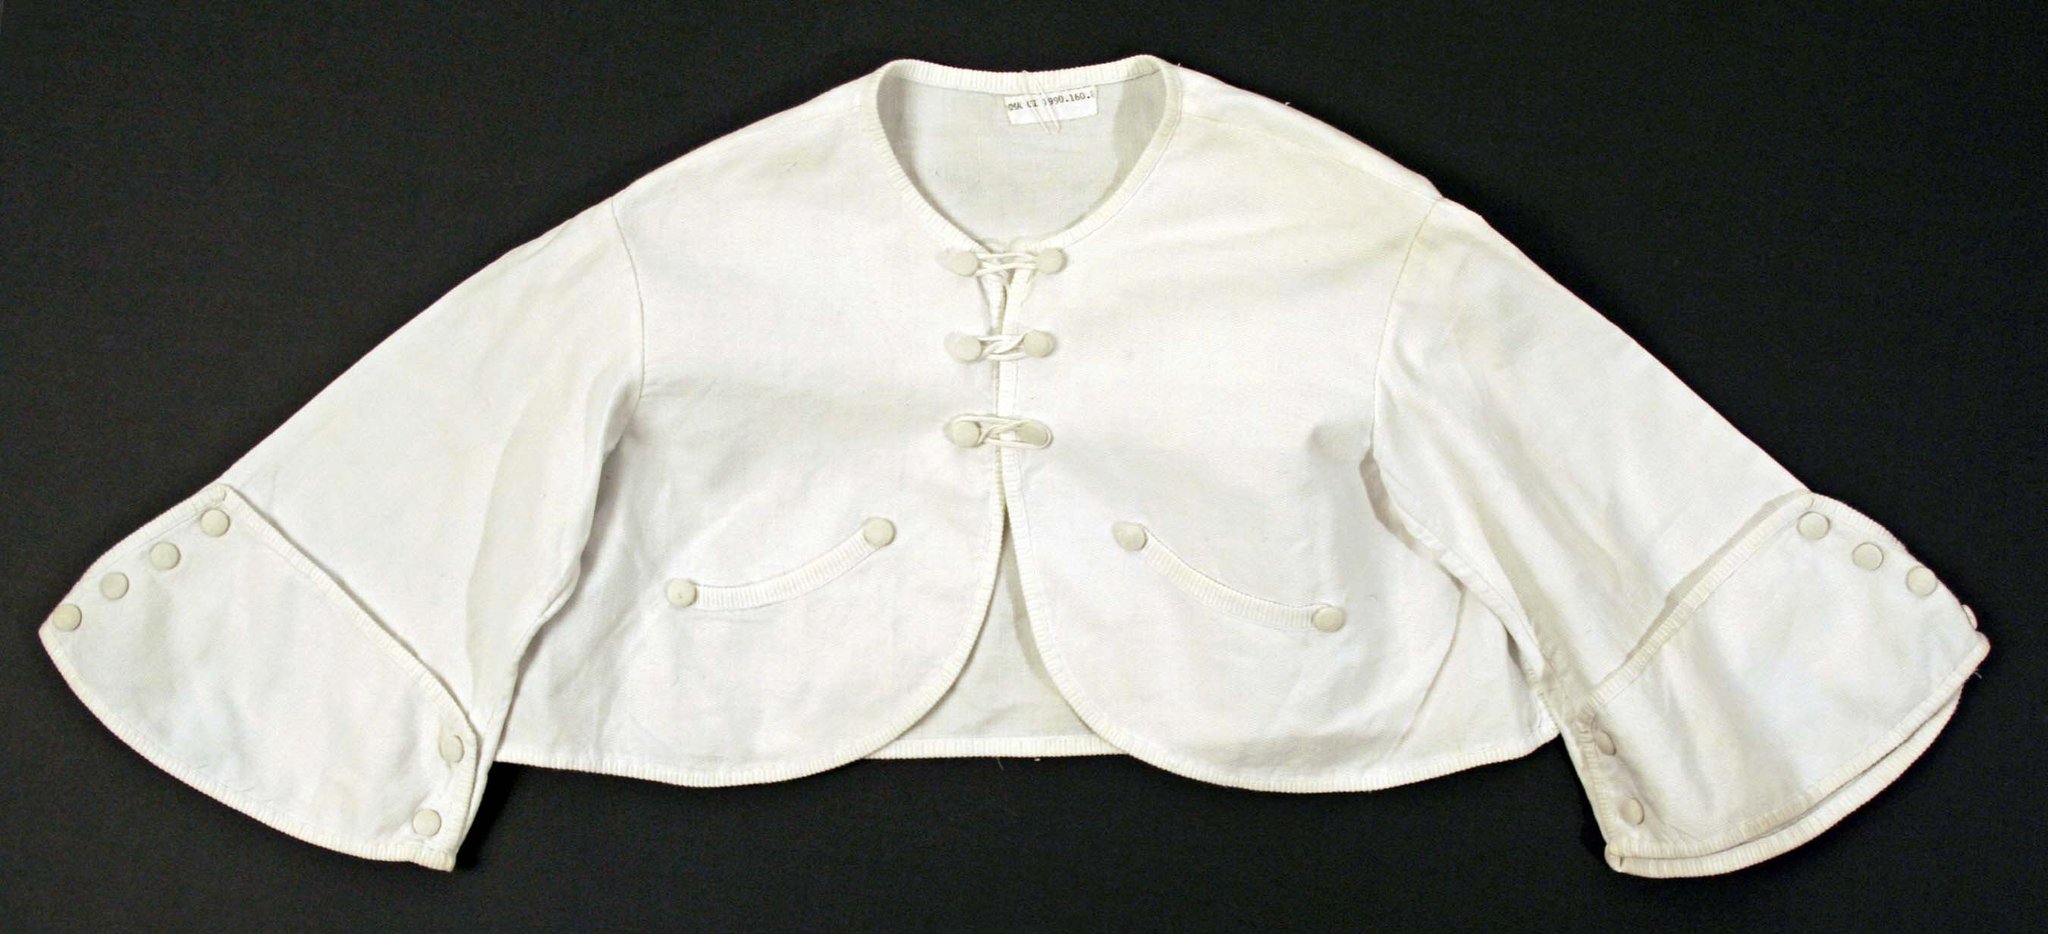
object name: jacket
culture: american or european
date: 1840-1859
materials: cotton